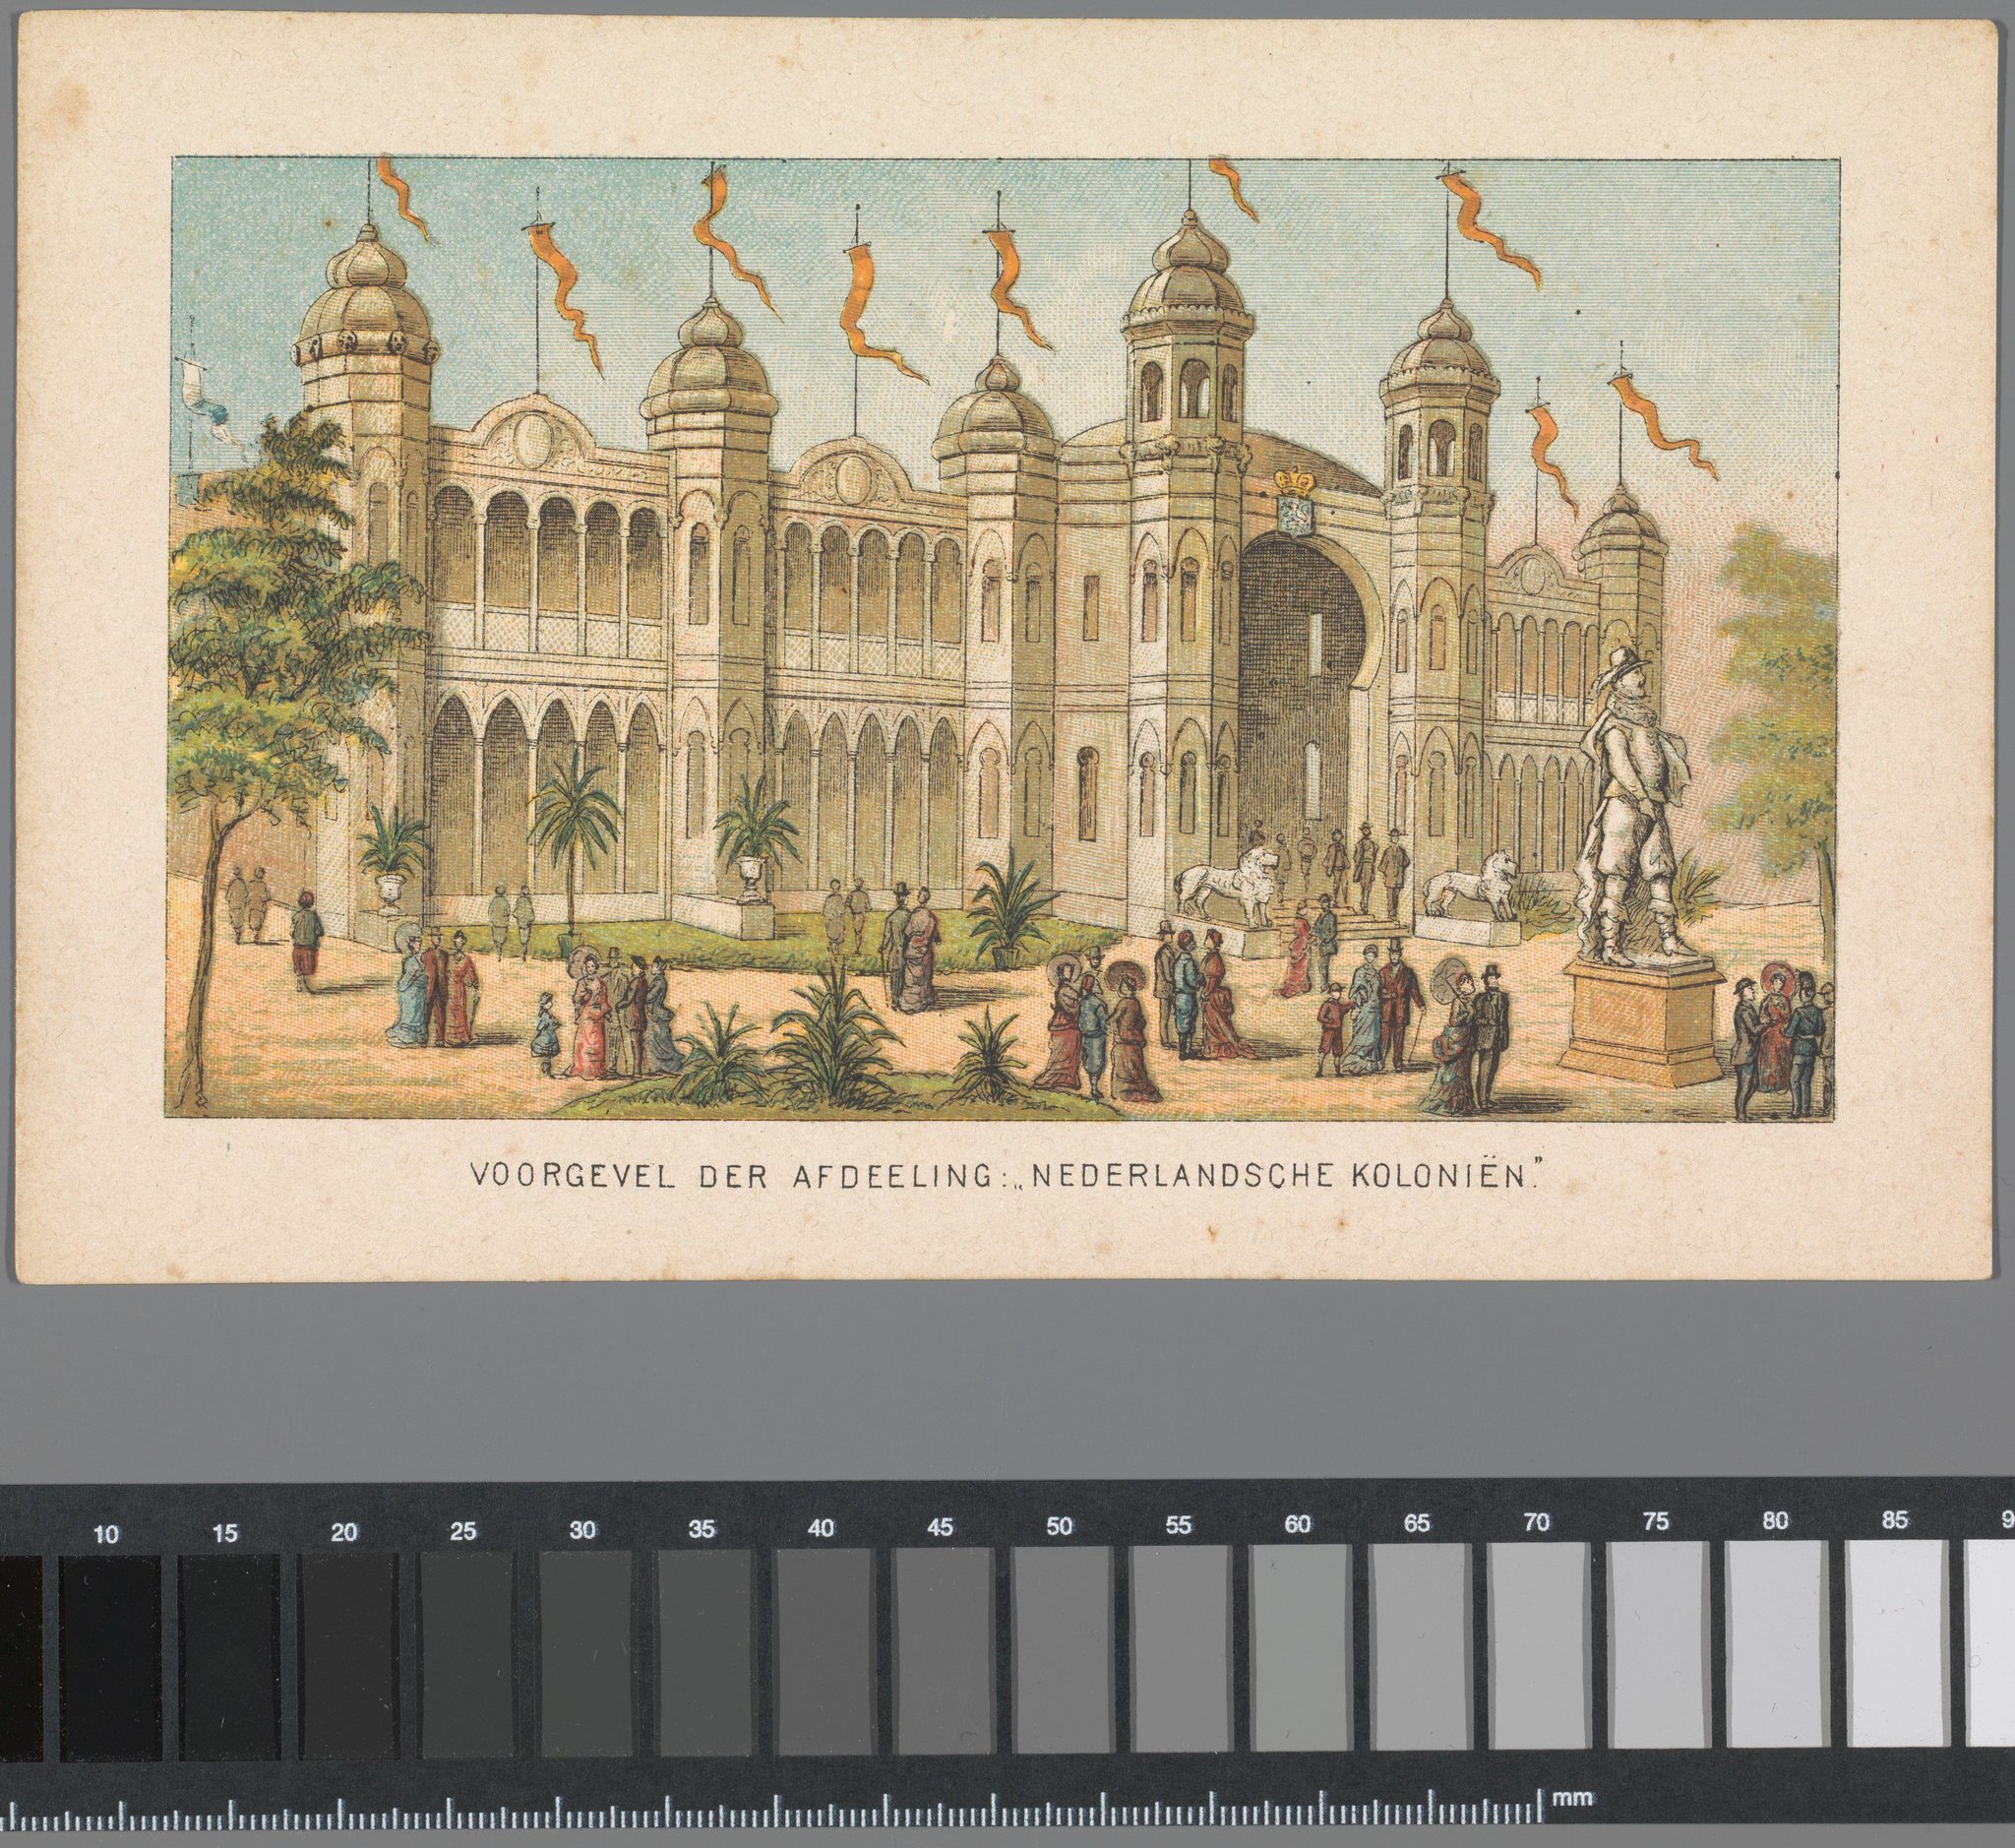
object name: print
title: Gebouw van de Nederlandse koloniën op de Wereldtentoonstelling in Amsterdam, 1883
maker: Anonymous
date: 1883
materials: paper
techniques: chromolithography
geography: amsterdam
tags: world fair, world exhibition, amsterdam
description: Gezicht op het gebouw voor de afdeling Nederlandse koloniën op de Wereldtentoonstelling op het Museumplein te Amsterdam. Onderdeel van een groep van zestien platen en een plattegrond van de Wereldtentoonstelling in Amsterdam van 1 mei tot 1 oktober 1883. Uitgave van het Nieuws van den Dag.